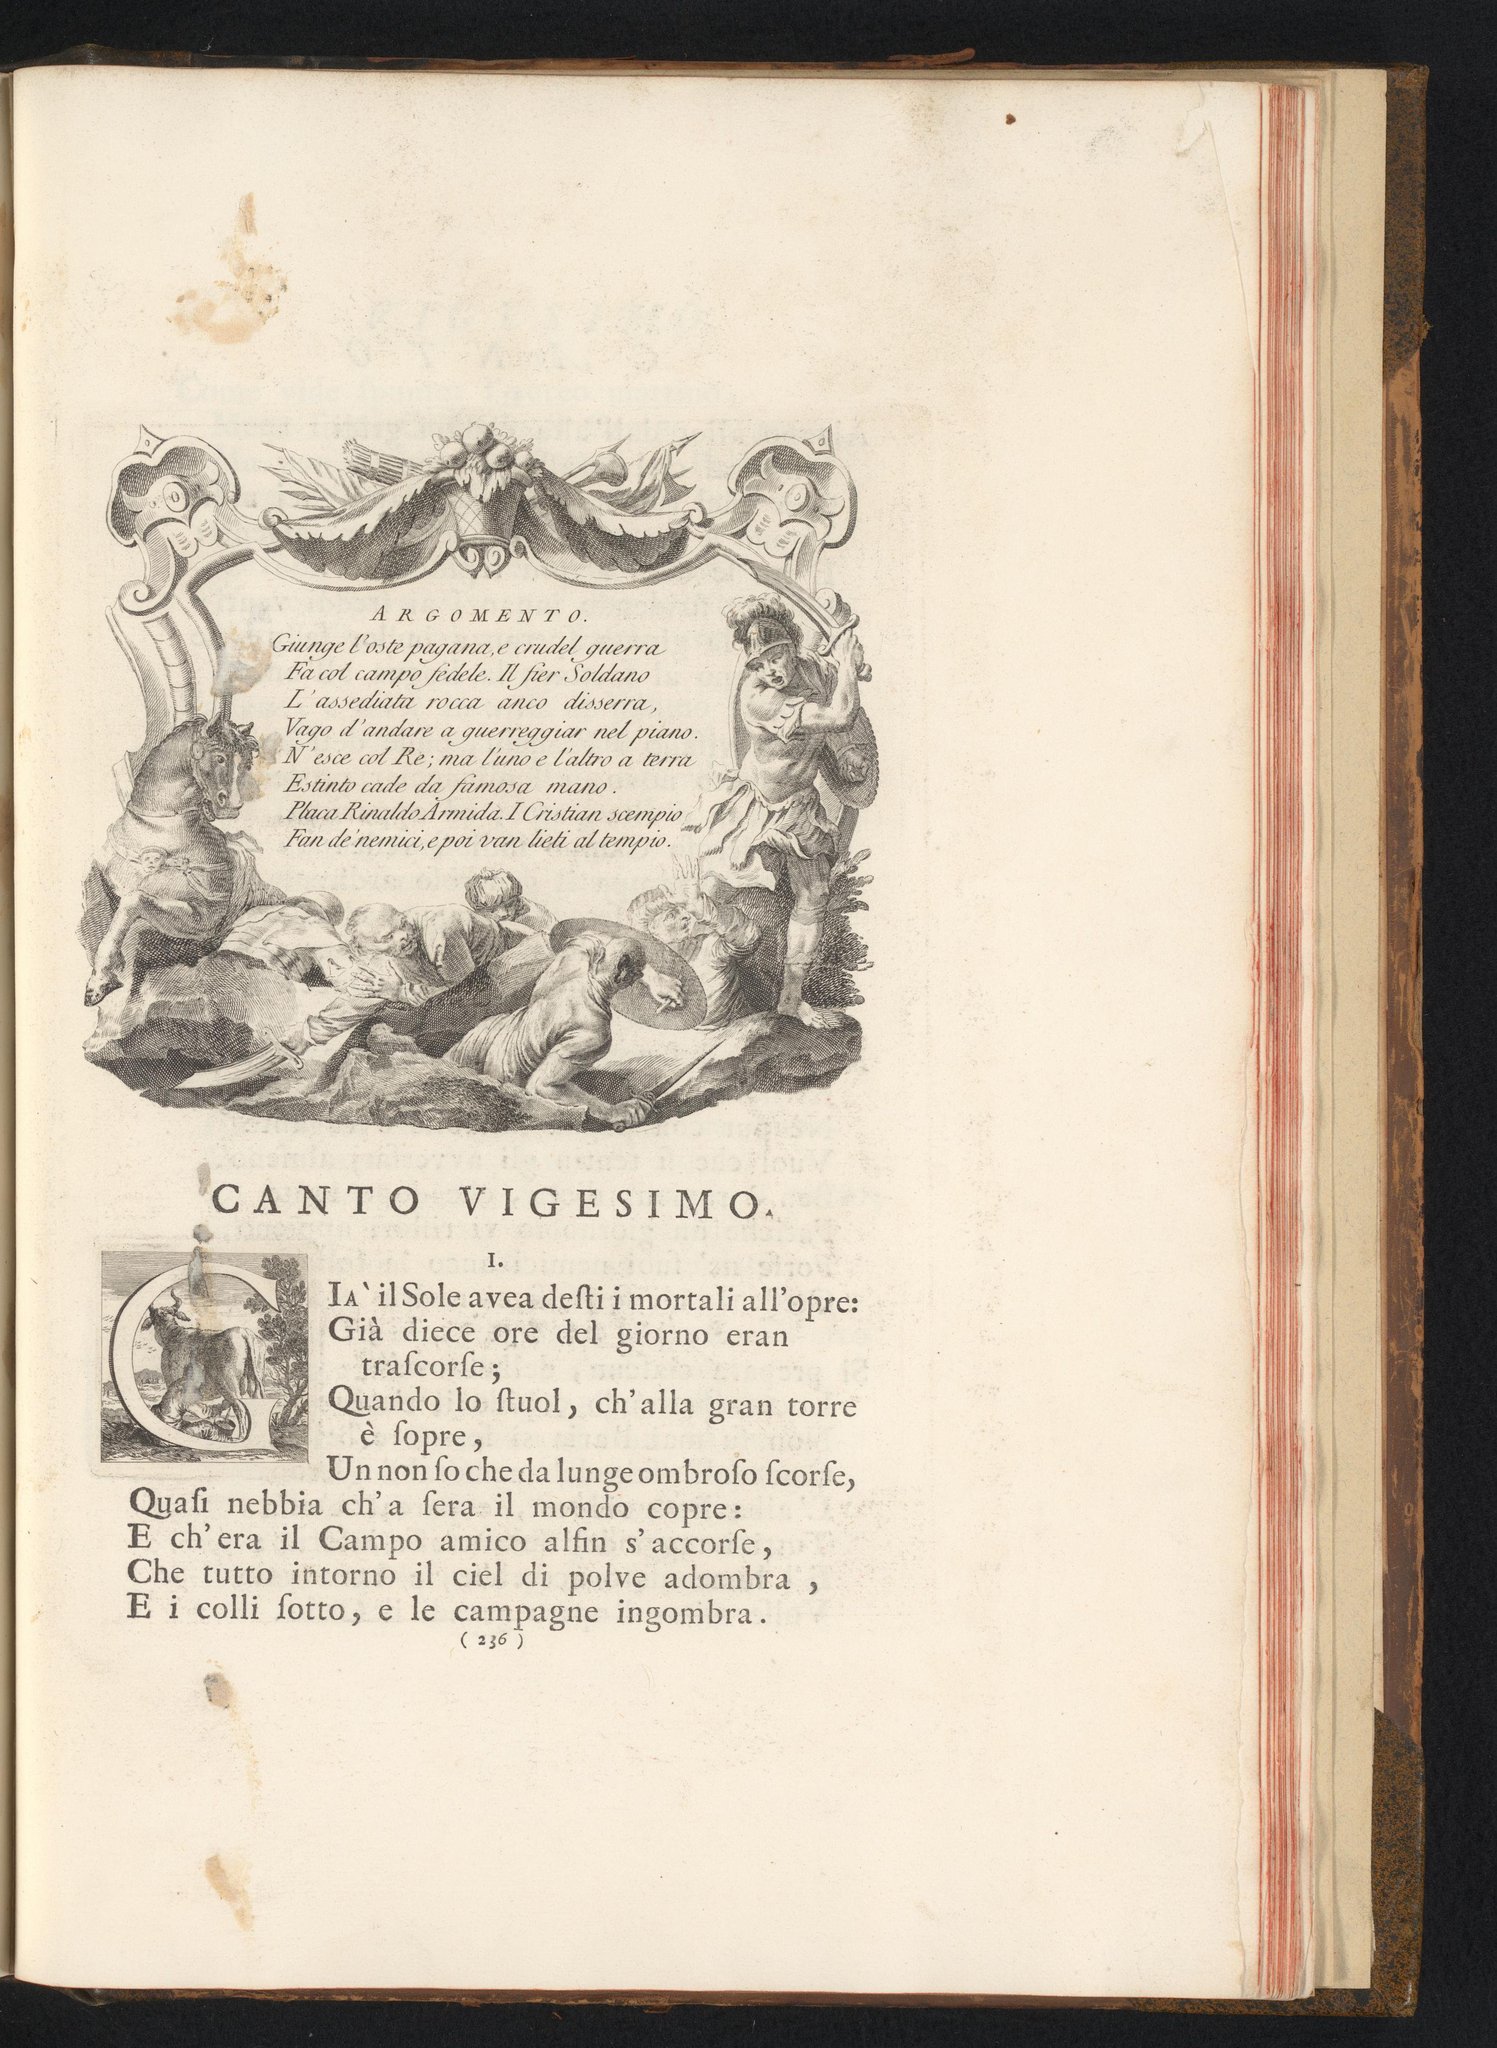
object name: print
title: Vechtende soldaten en initiaal G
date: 1745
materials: paper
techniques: etching, letterpress printing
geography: venice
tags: initial, battle, (scenes from) specific works of literature: tasso, gerusalemme liberata, milking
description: Prent uit: Tasso, Torquato. La Gerusalemme liberata di Torquato Tasso con le figure de Giambatista Piazzetta. Venetië: Giambatista Albrizzi, 1745.